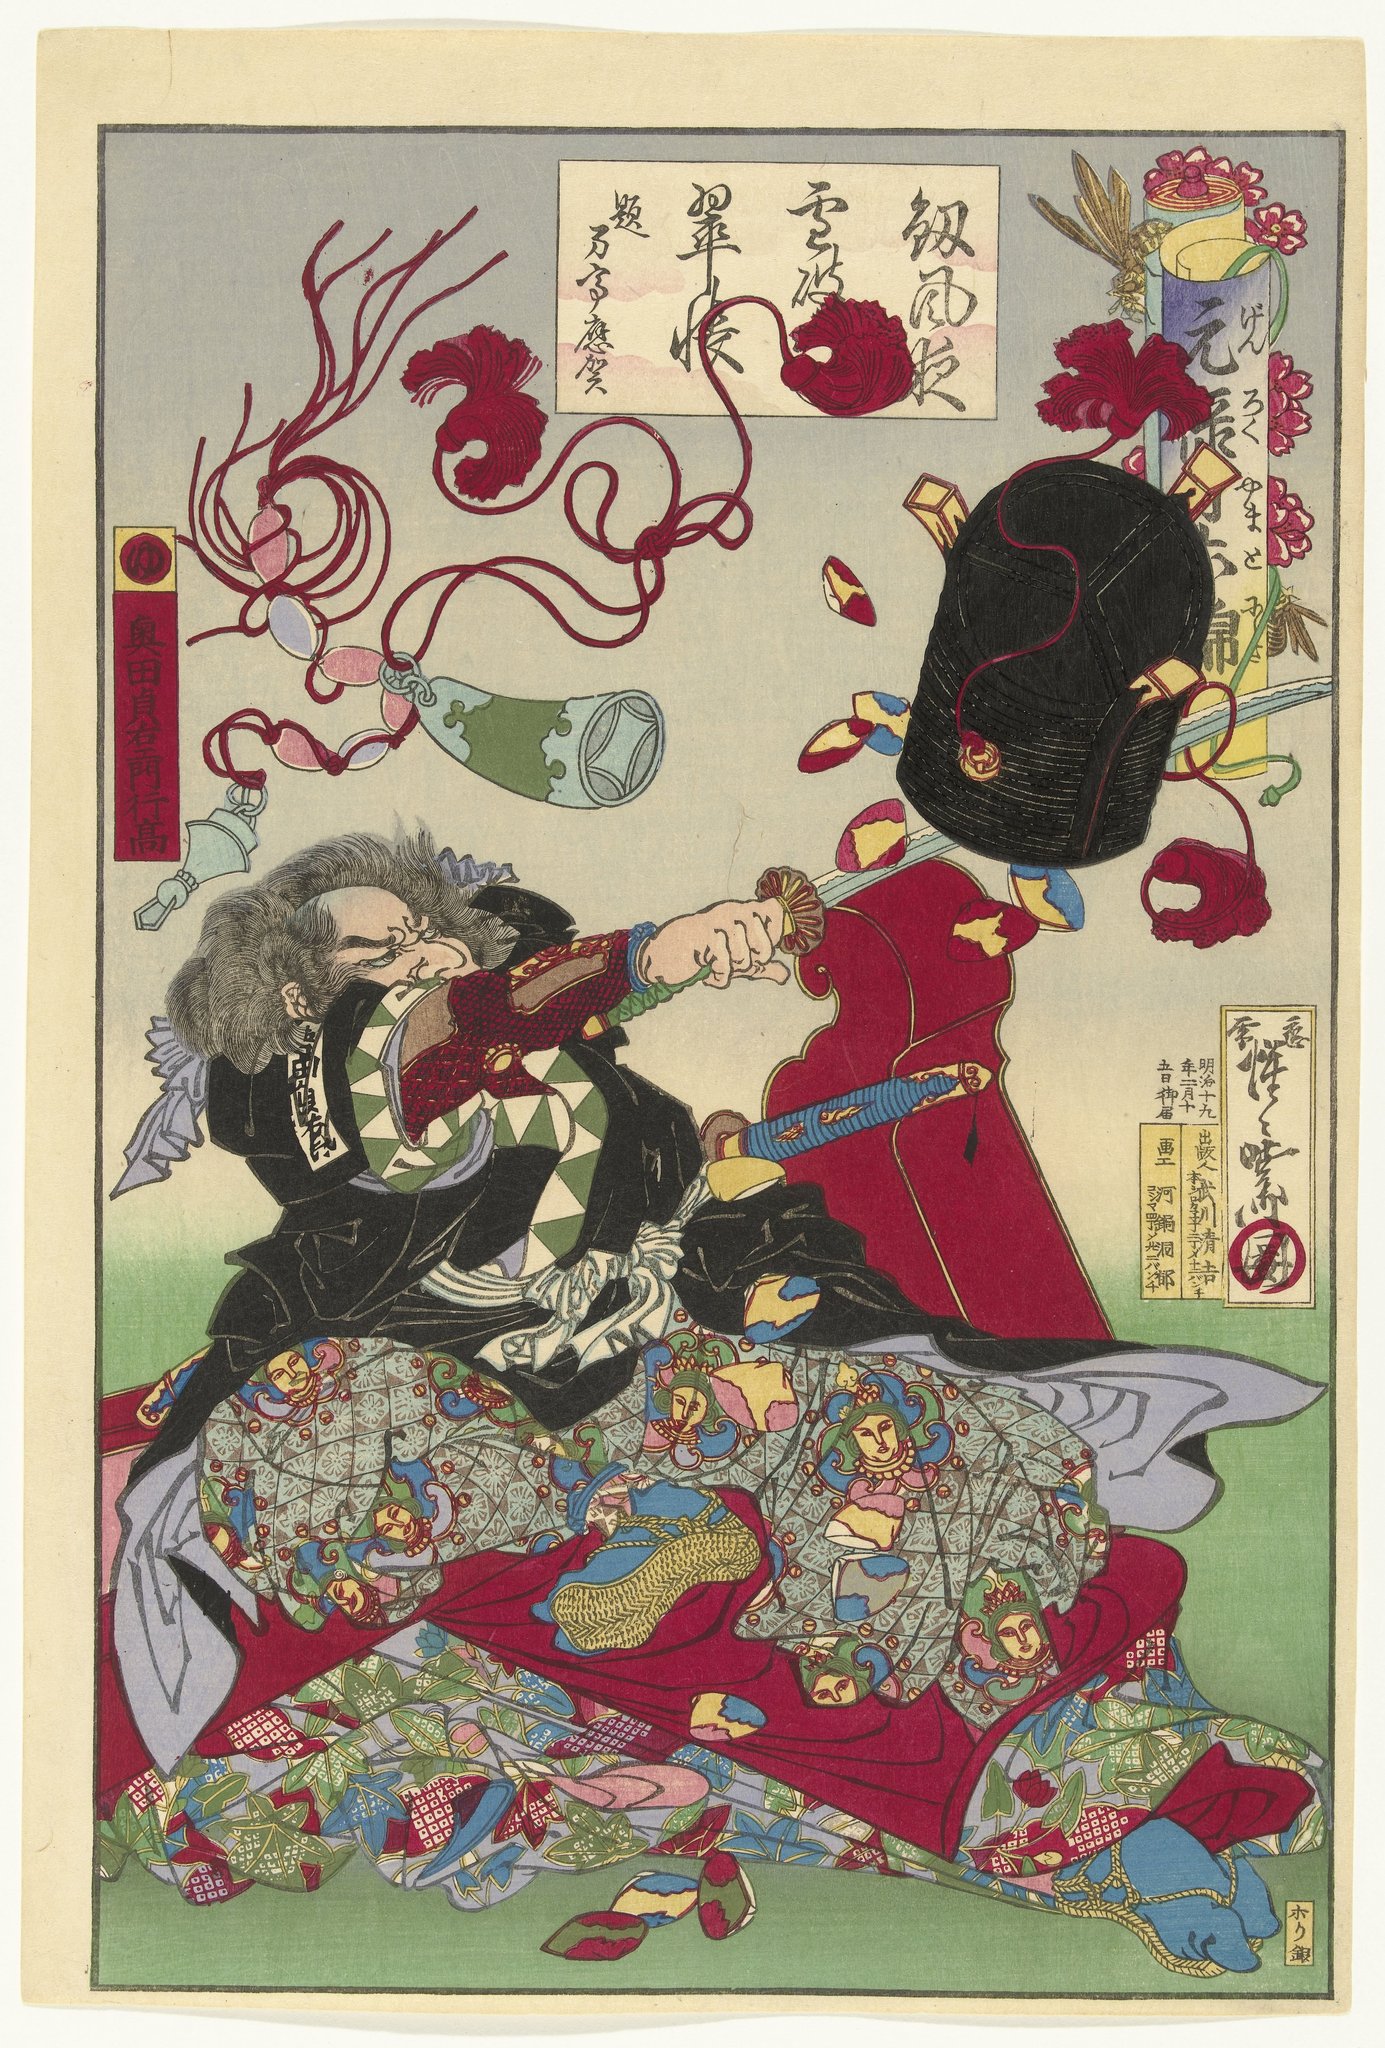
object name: print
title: Japanse brokaten uit de Genroku periode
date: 1886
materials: paper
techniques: woodcut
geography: japan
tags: scallop, shell ~ ornament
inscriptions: date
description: Okuda Sademon Yukitaka met zijn zwaard slaand naar een zwarte kist waarin een schelpenspel; om hem heen onderdelen van de doos en gekleurde schelpen.